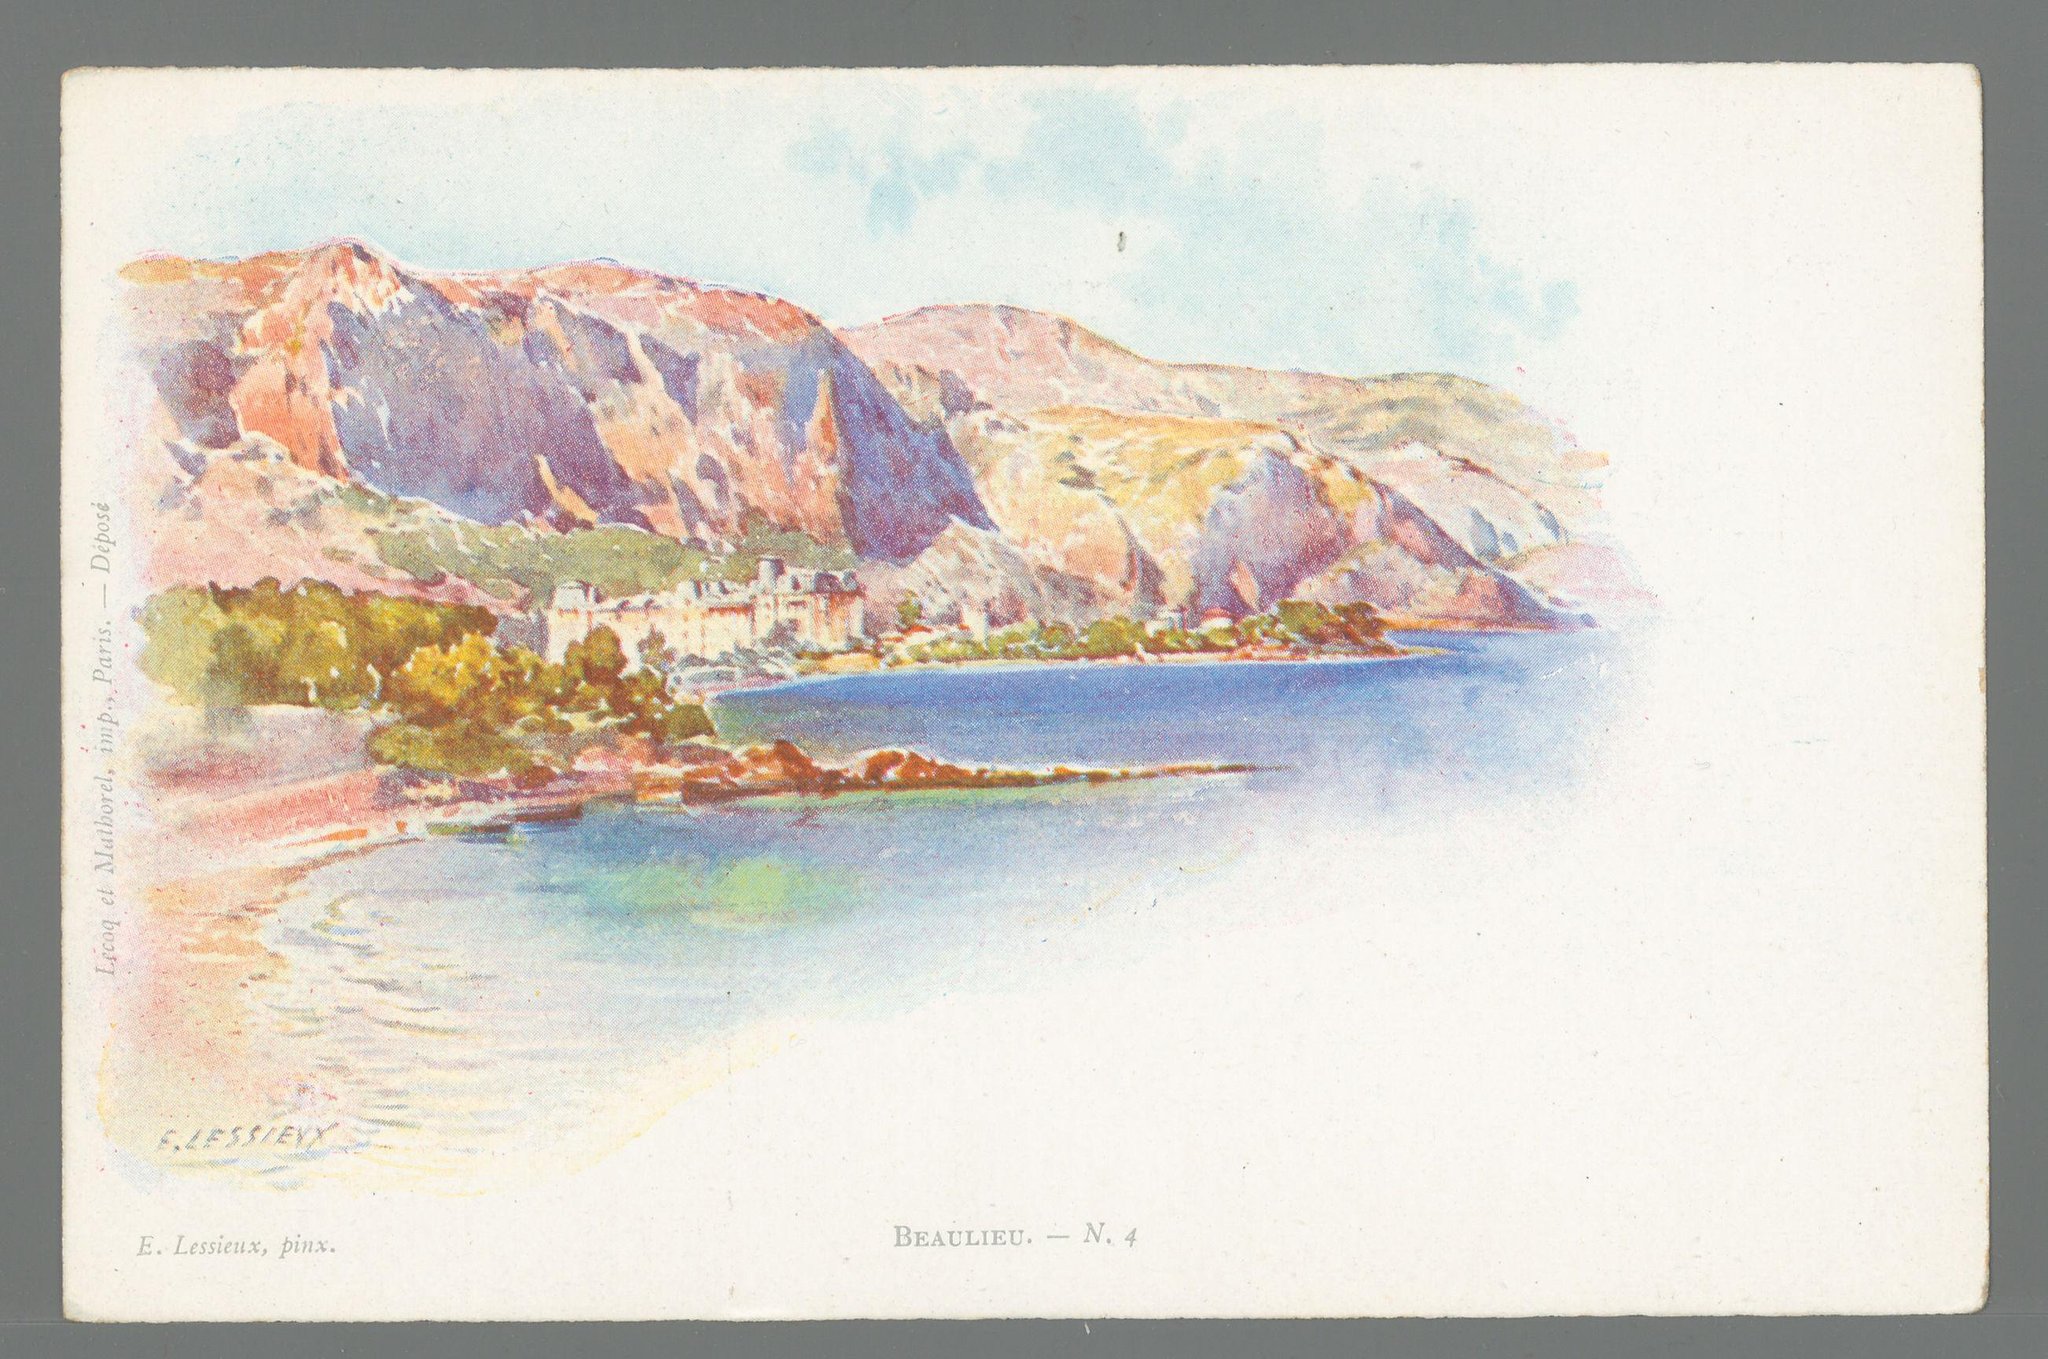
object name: reproduction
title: Beaulieu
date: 1892-1904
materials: cardboard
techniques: writing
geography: paris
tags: landscapes with waters, waterscapes, seascapes (in the temperate zone), rocks